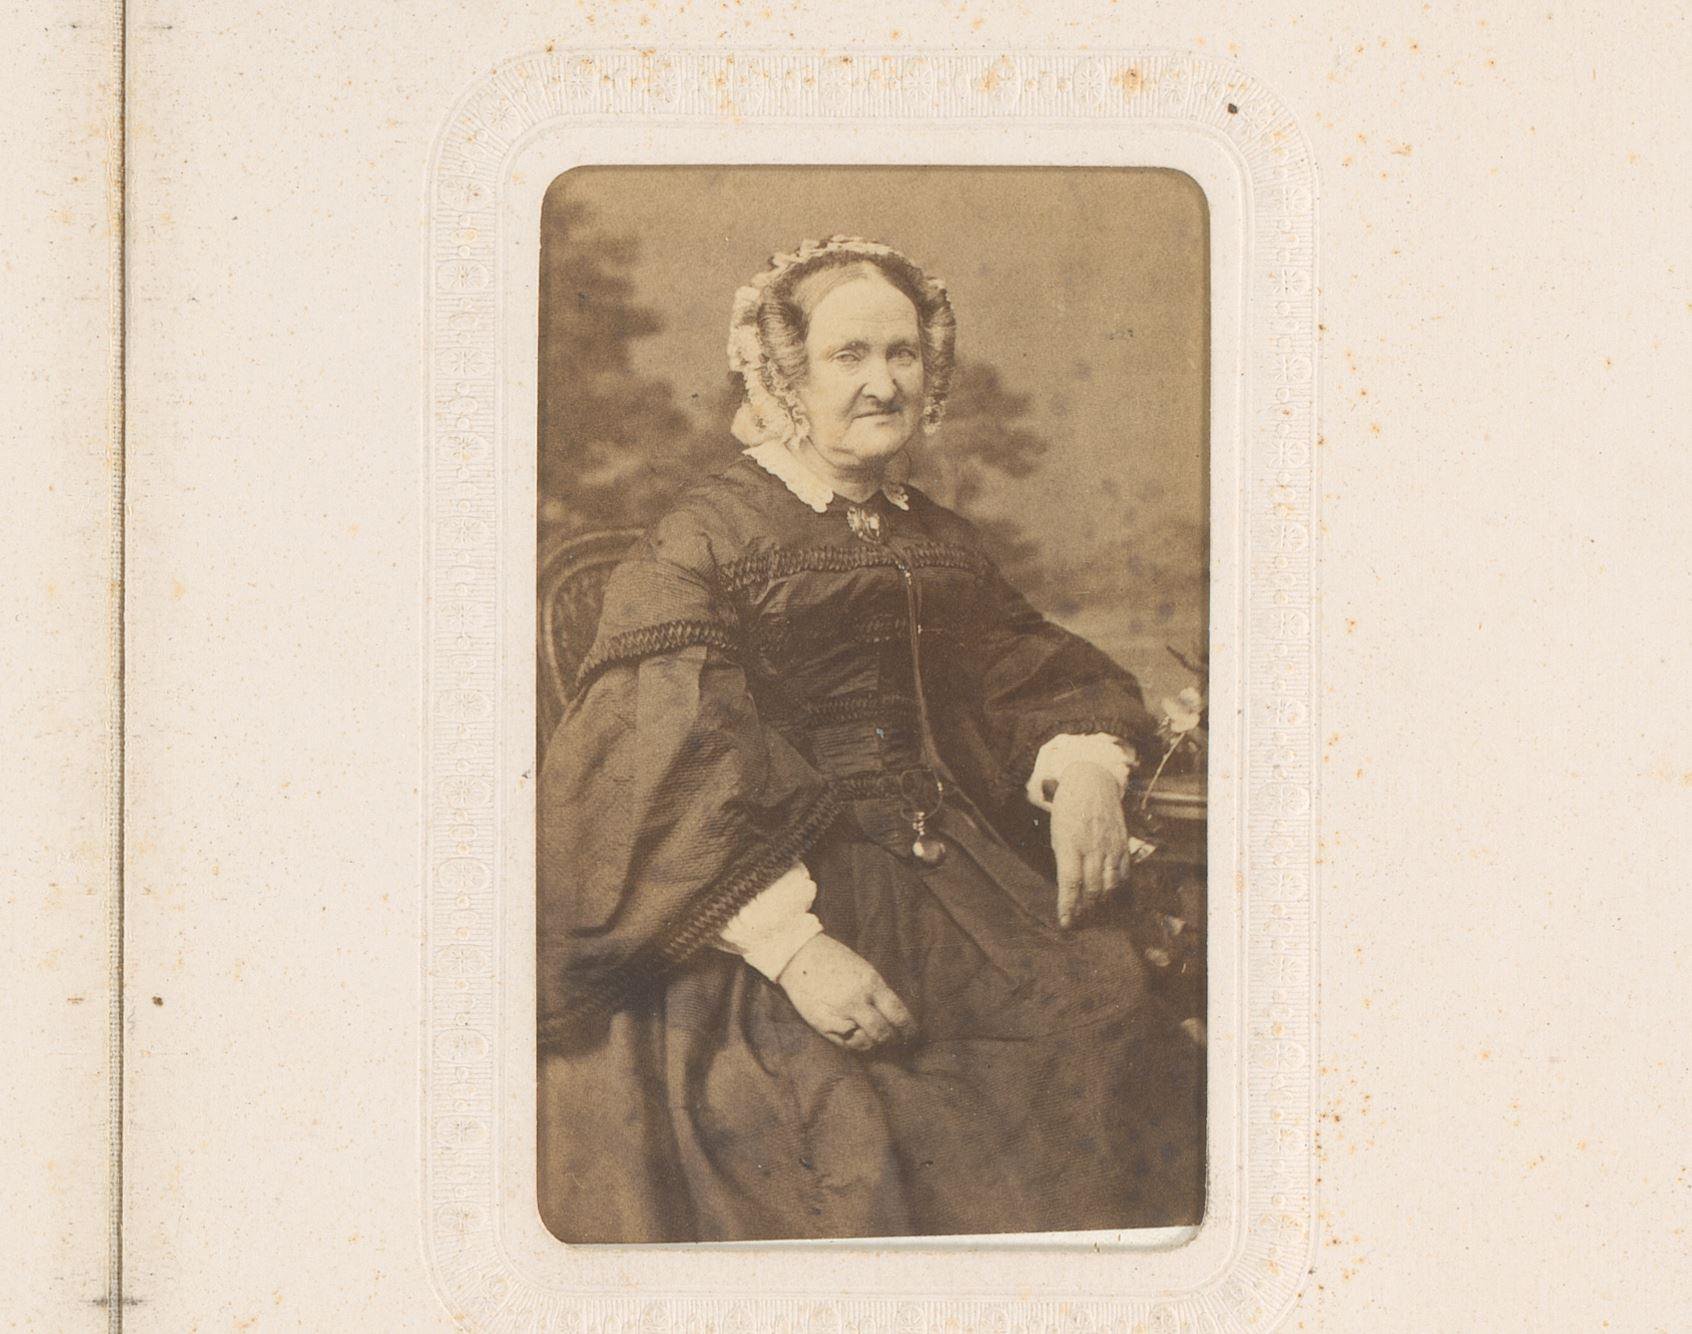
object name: photograph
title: Portret van een zittende oude vrouw met muts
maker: Anonymous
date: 1860-1900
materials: cardboard, photographic support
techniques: albumen print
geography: netherlands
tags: sitting figure - aa - female human figure, historical persons - bb - woman, old woman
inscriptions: annotation: ‘Overgrootouder’